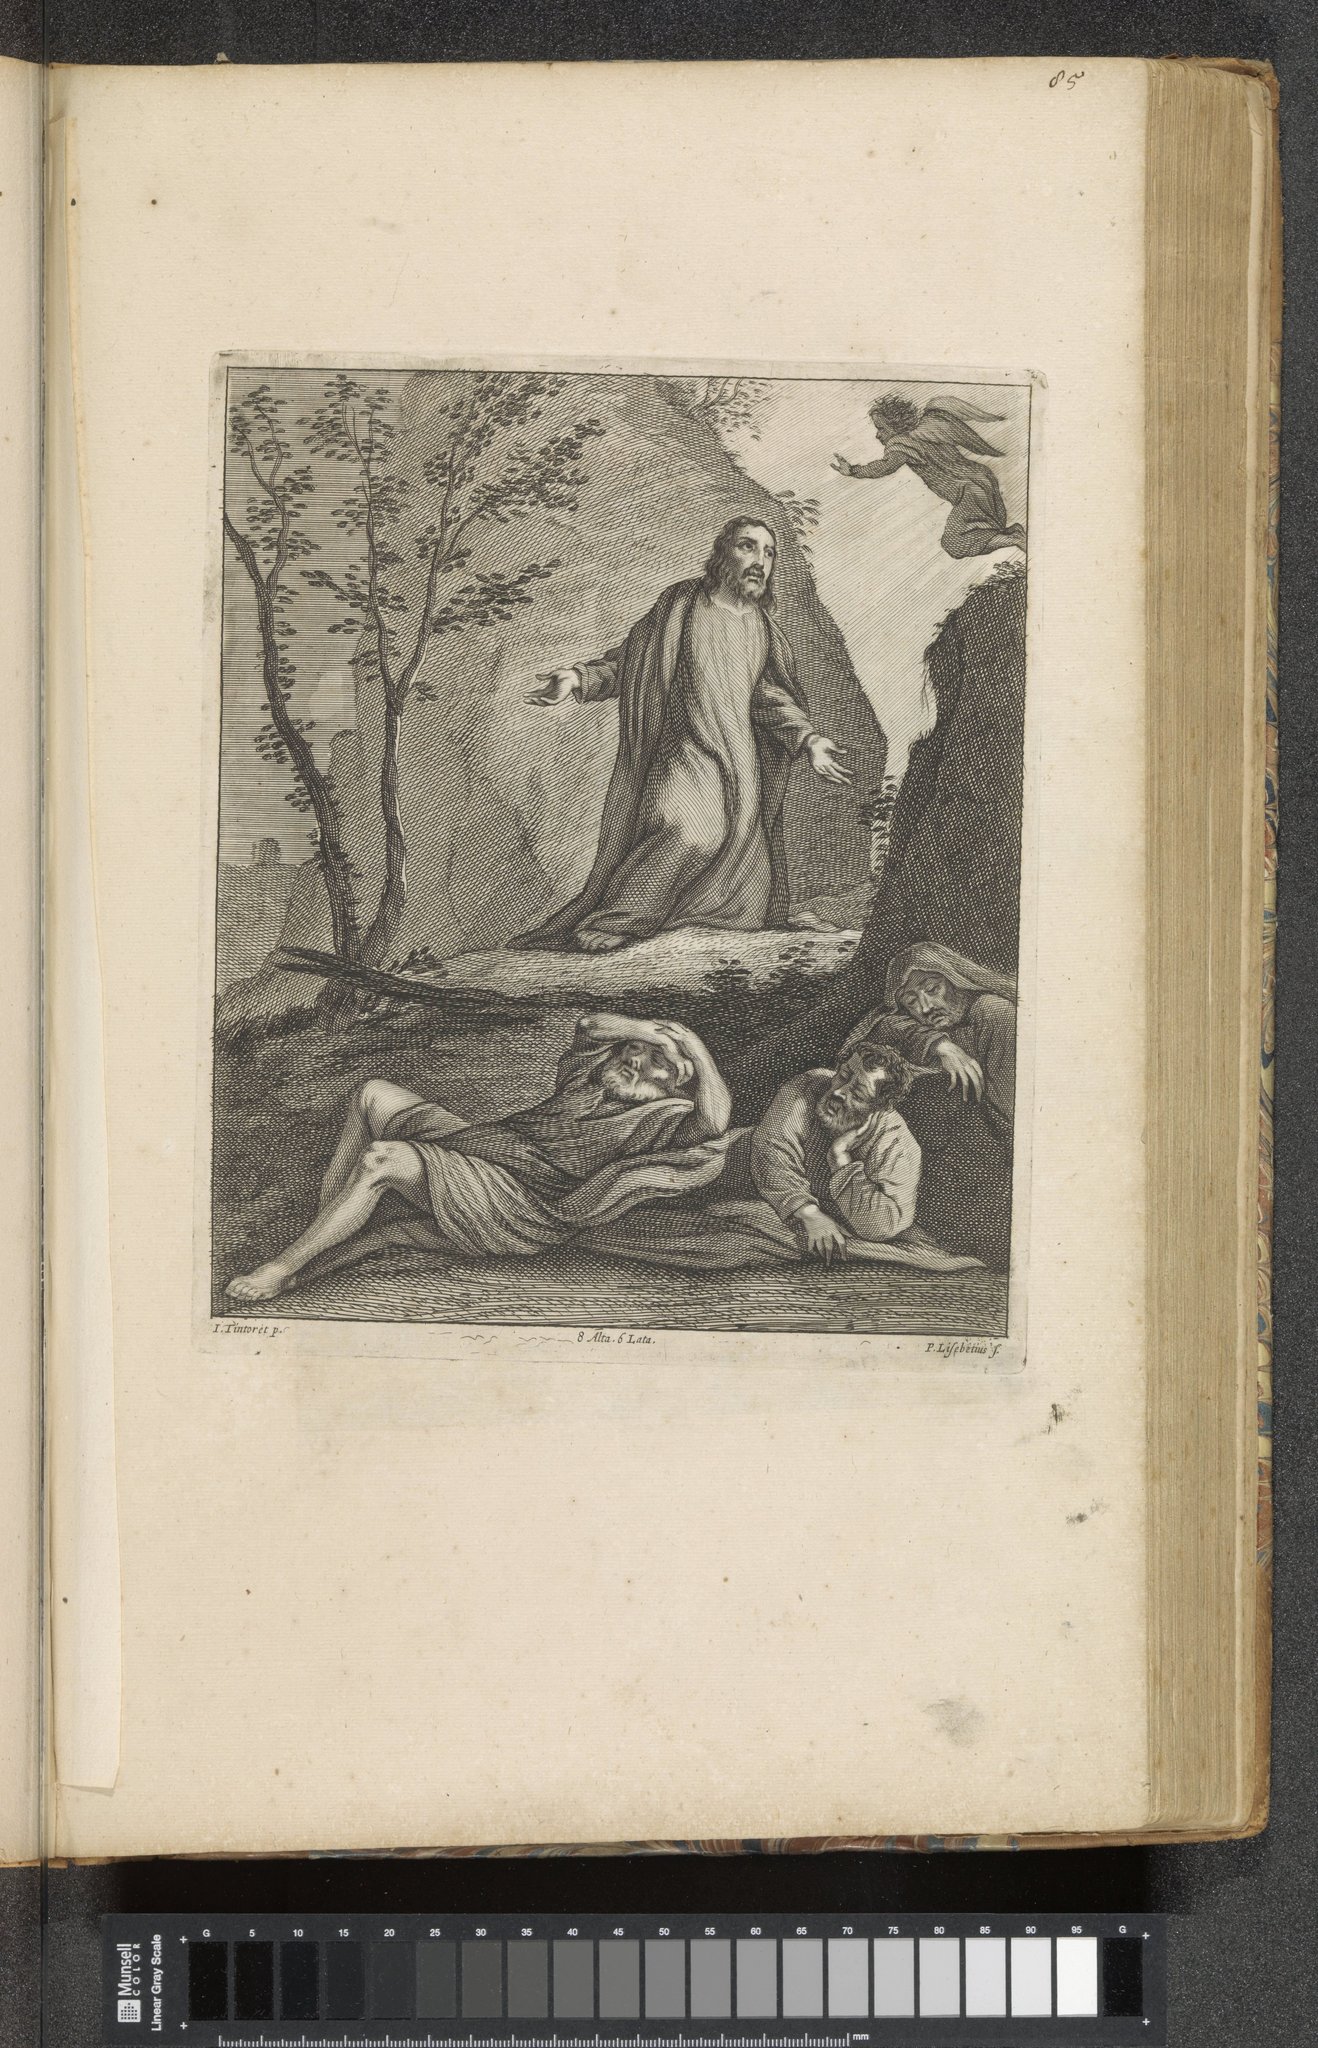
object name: album leaf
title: Christus in de hof van Getsemane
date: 1660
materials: paper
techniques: engraving, etching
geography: antwerp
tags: christ's prayer in the garden of gethsemane during the night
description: David Teniers heeft waarschijnlijk van alle schilderijen uit de collectie van Leopold Willem van Oostenrijk een olieverfstudie op doek of paneel vervaardigd (zgn. pasticcio), die als voorbeeld voor de prentmakers diende. Het is niet altijd duidelijk of de pasticci door hem zijn gemaakt of door zijn atelier. Niet alle pasticci zijn overgeleverd.